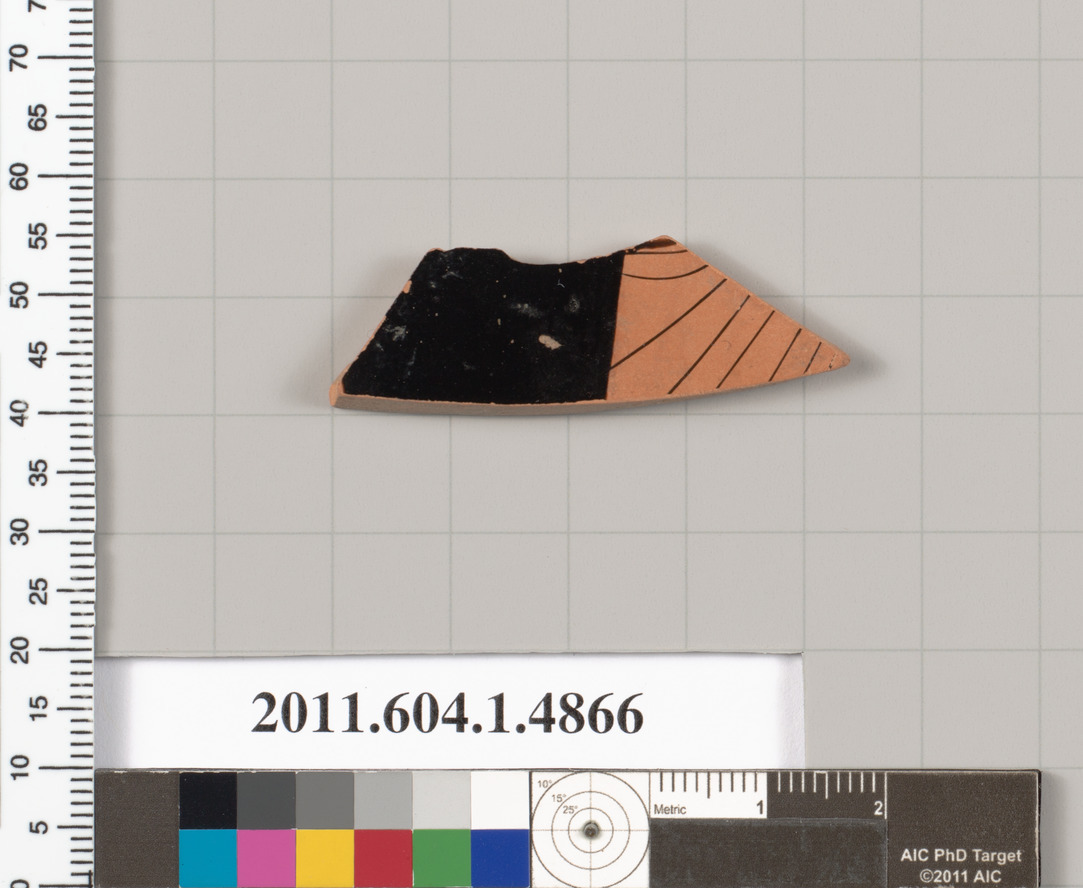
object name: kylix fragment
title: Terracotta fragment of a kylix (drinking cup)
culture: greek, attic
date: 475-451 BCE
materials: terracotta